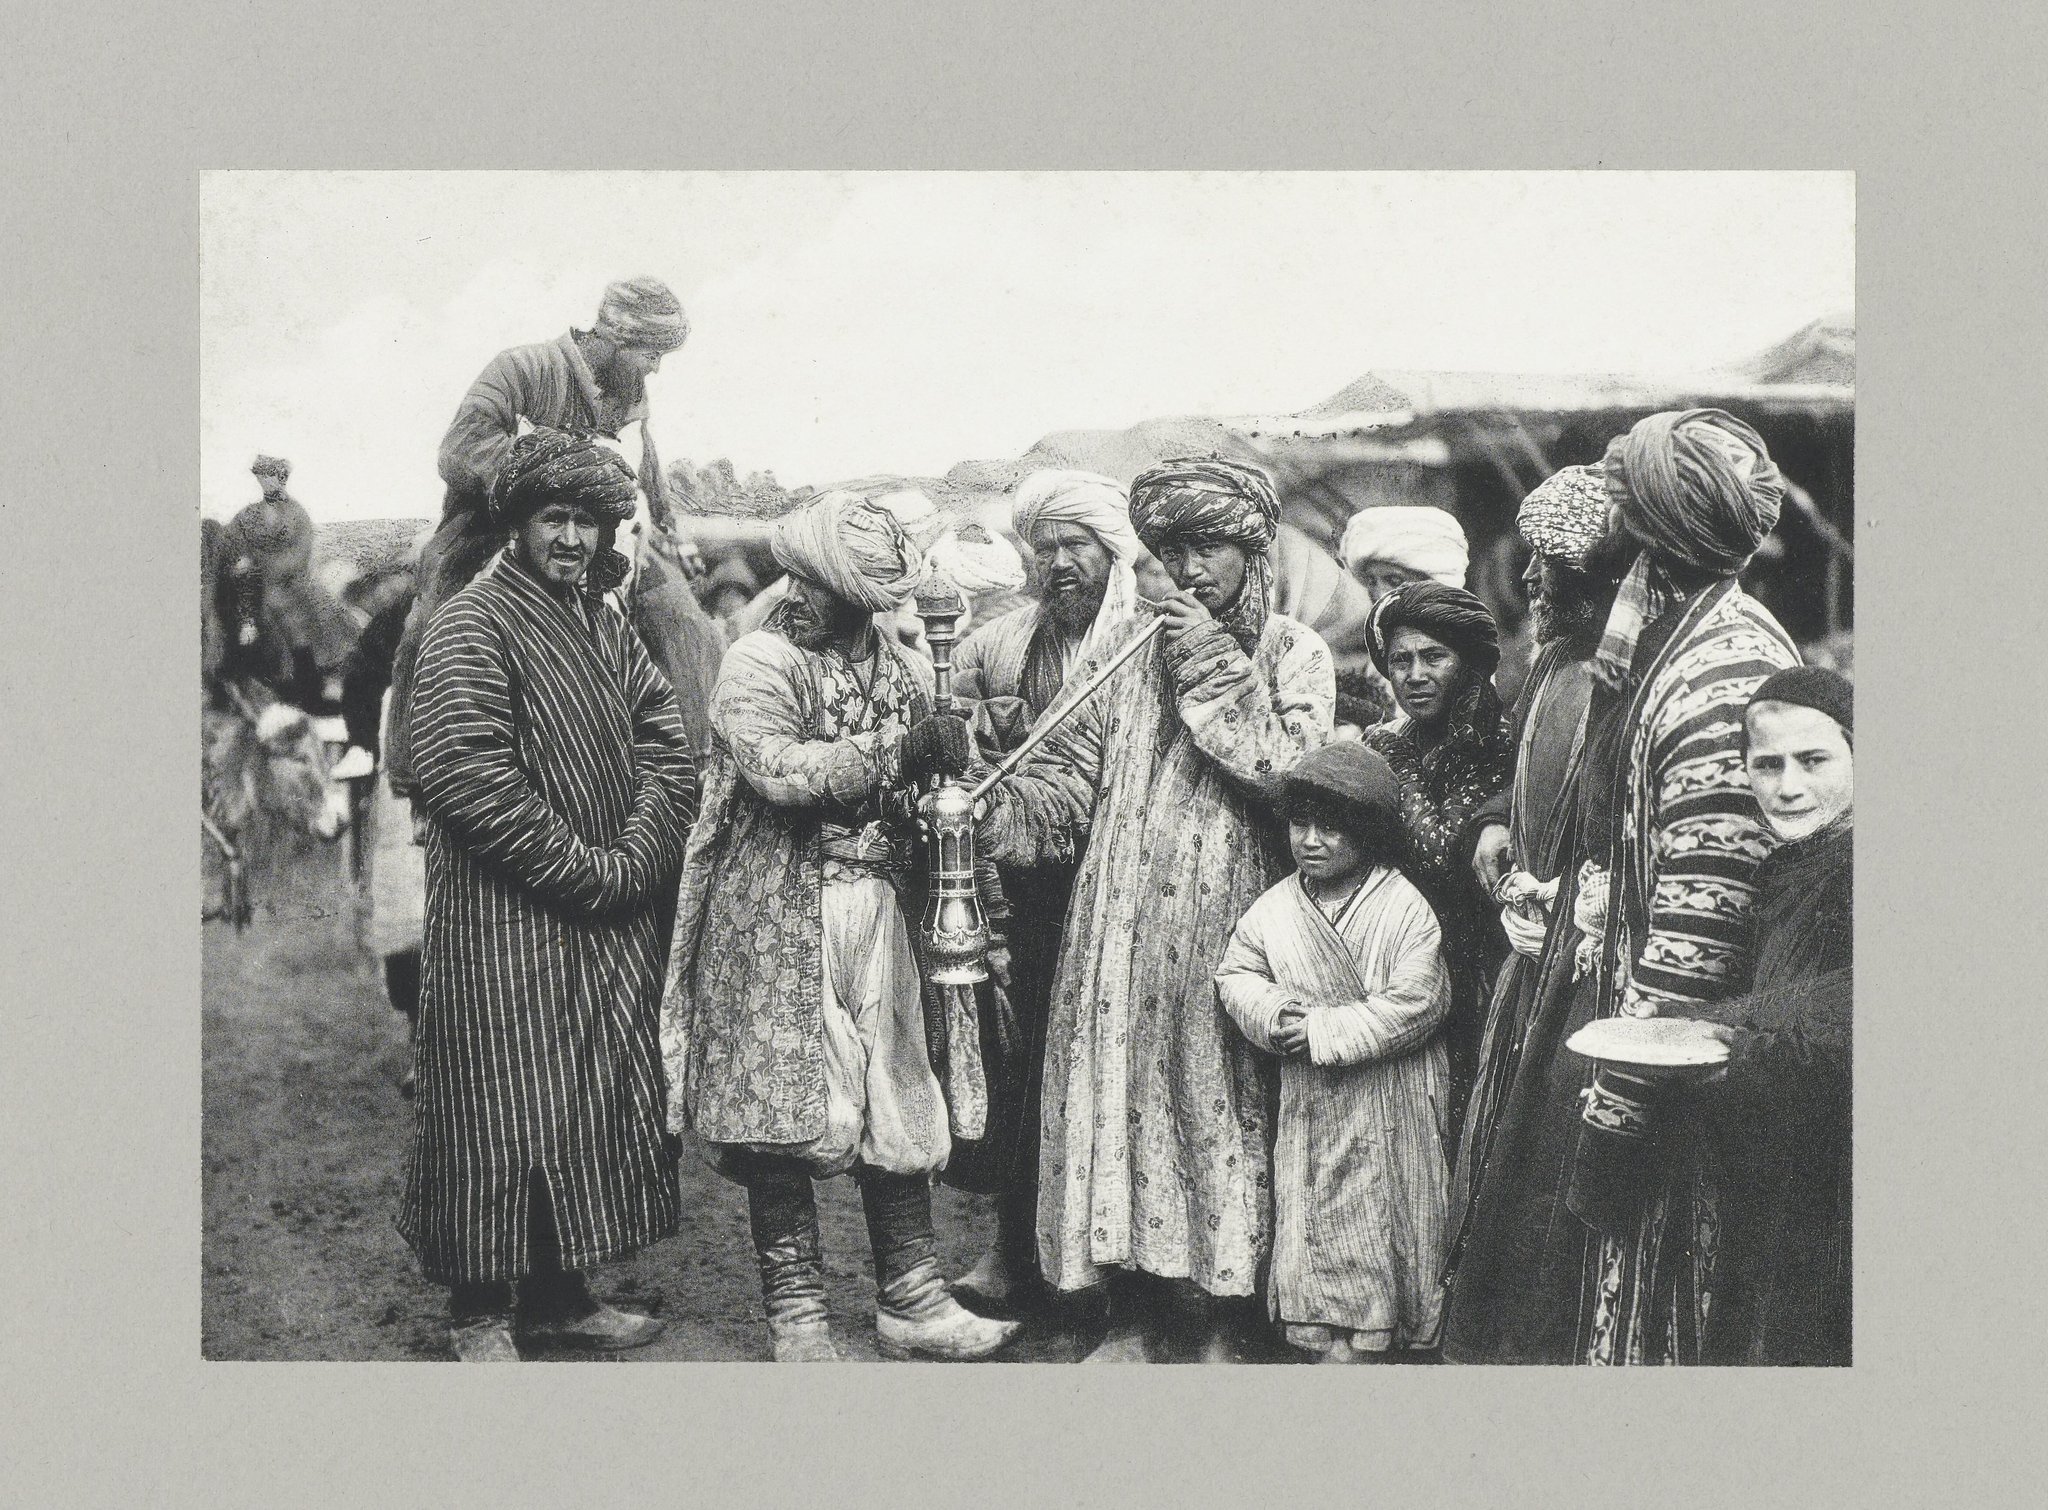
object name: photomechanical print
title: Straat met mensen in Samarkand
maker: Anonymous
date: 1895-1915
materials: cardboard, paper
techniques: photograph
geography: samarqand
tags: samarqand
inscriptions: annotation: ‘22. Samarkand.’